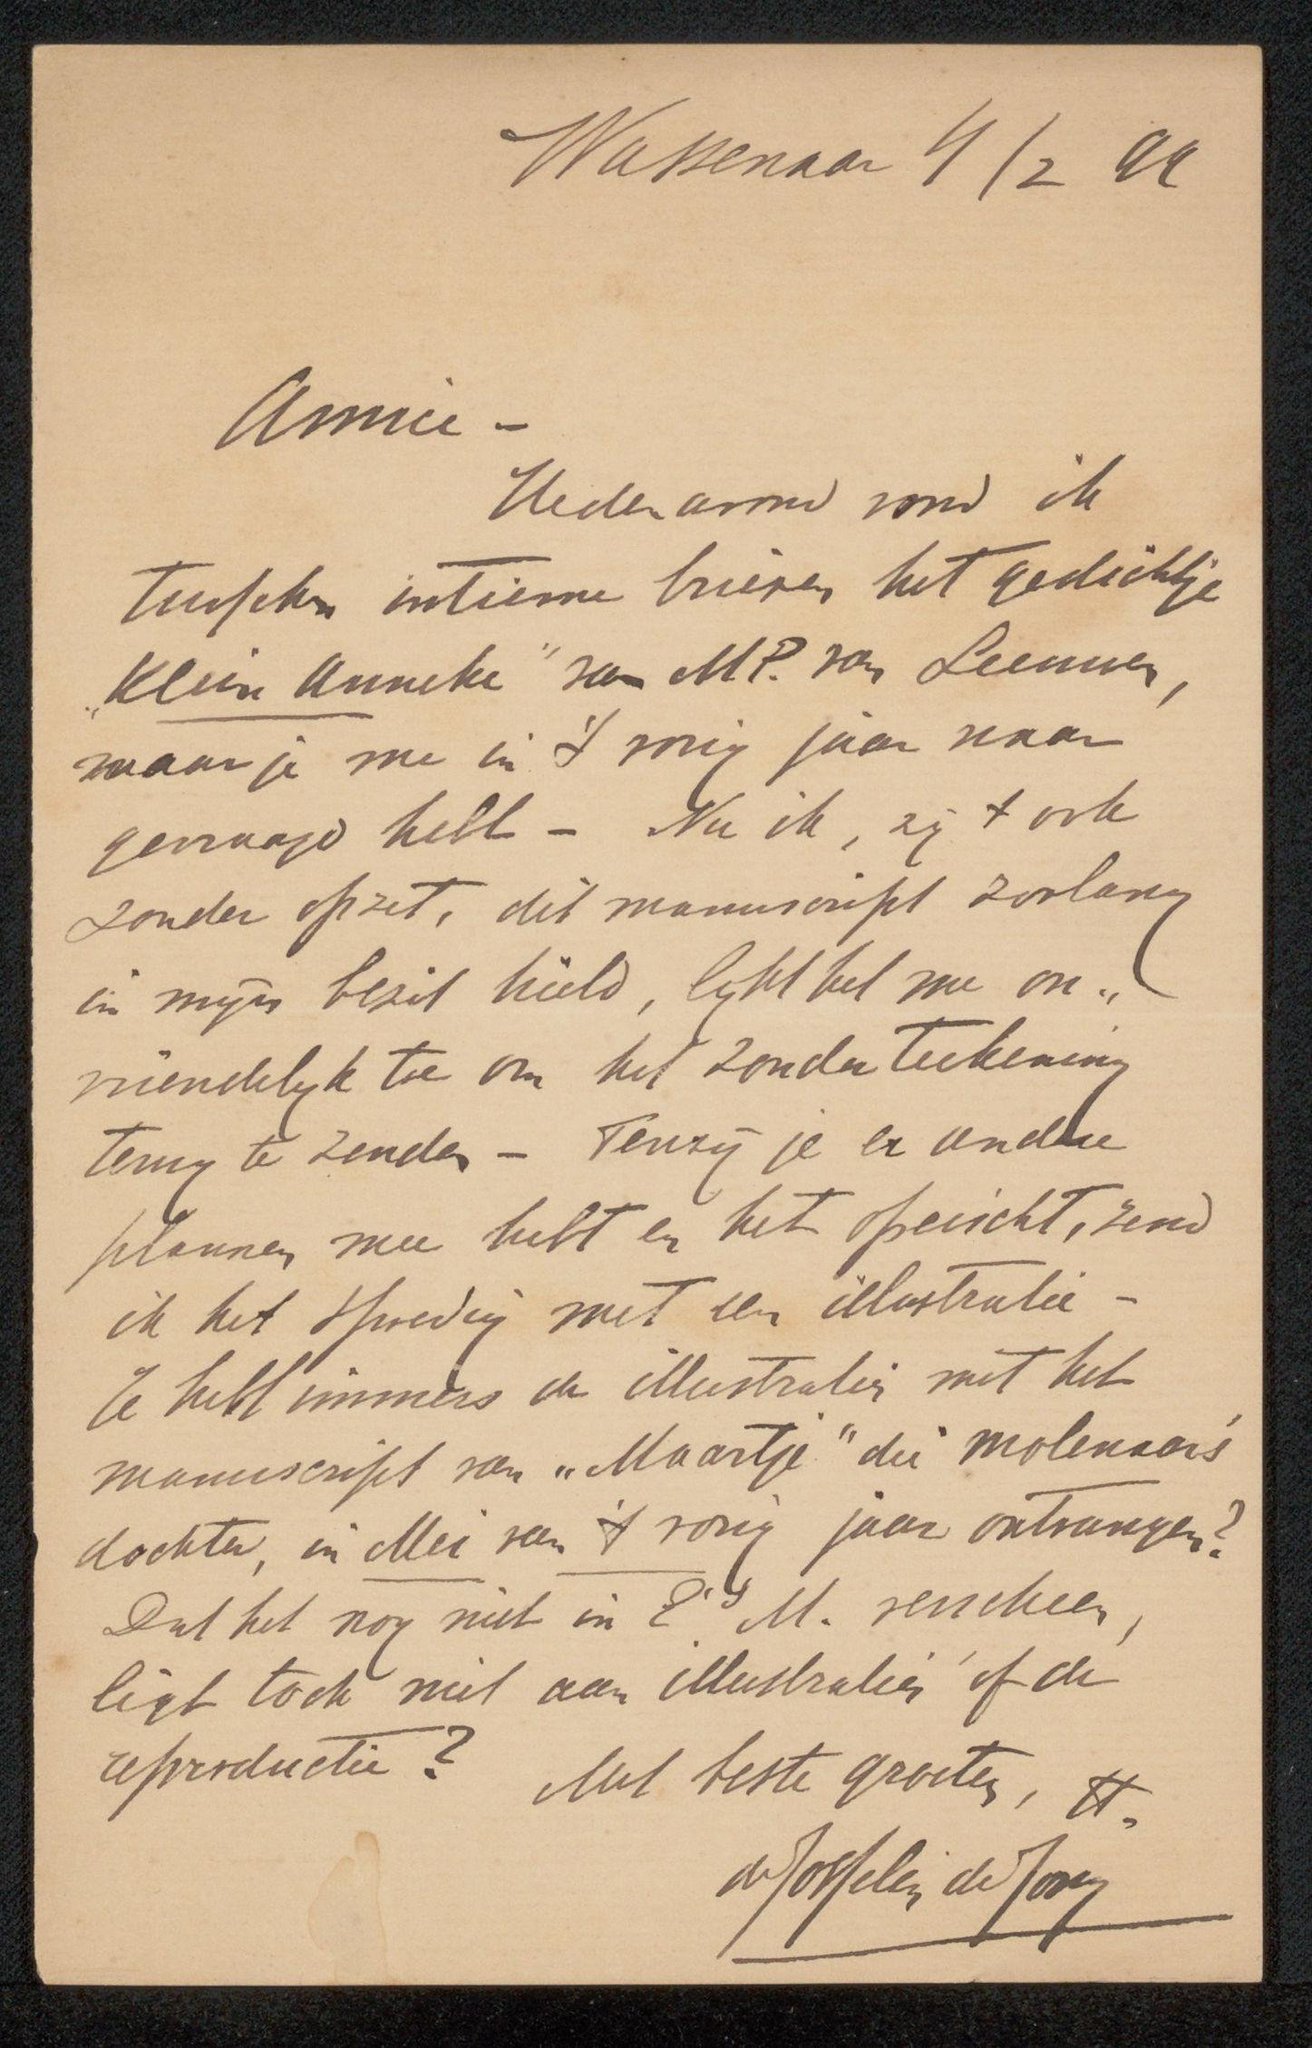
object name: letter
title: Brief aan Philip Zilcken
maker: pieter de josselin de jong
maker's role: draughtsman, painter, print maker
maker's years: 1861-1906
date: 1894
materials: ink, paper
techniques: writing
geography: wassenaar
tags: the hague, philip zilcken, drawing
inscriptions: collector's mark: ‘RPK’